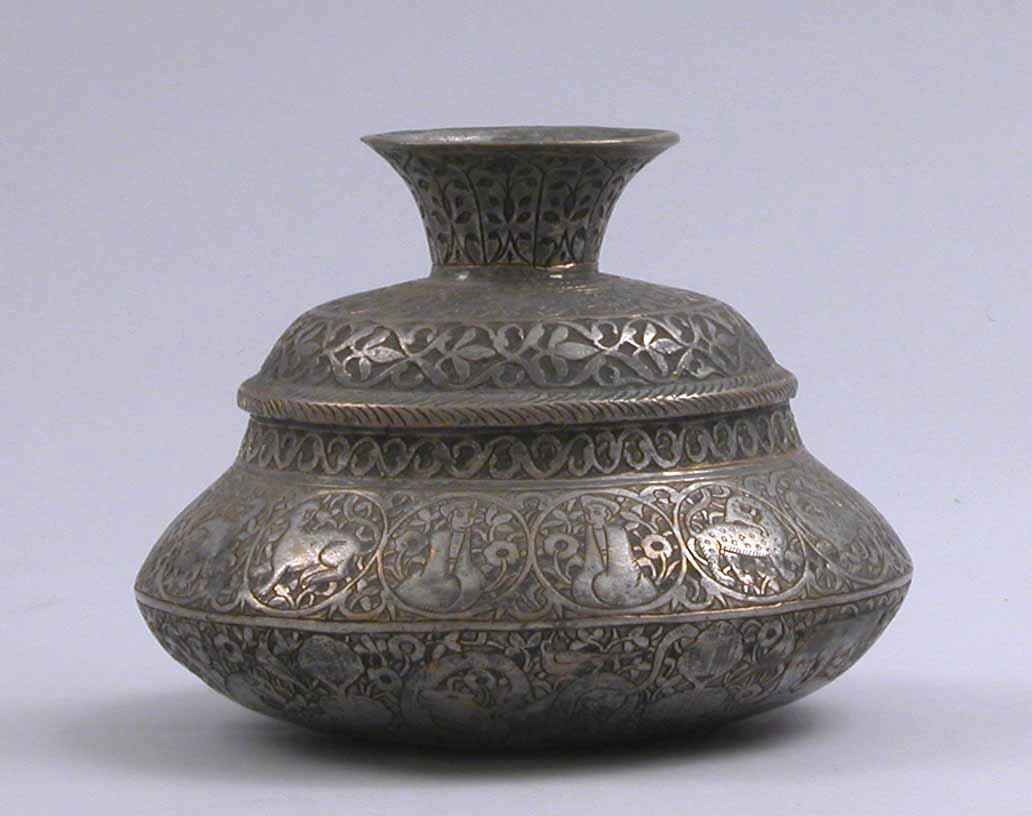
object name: vase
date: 1801-1900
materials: copper alloy, silver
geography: iran